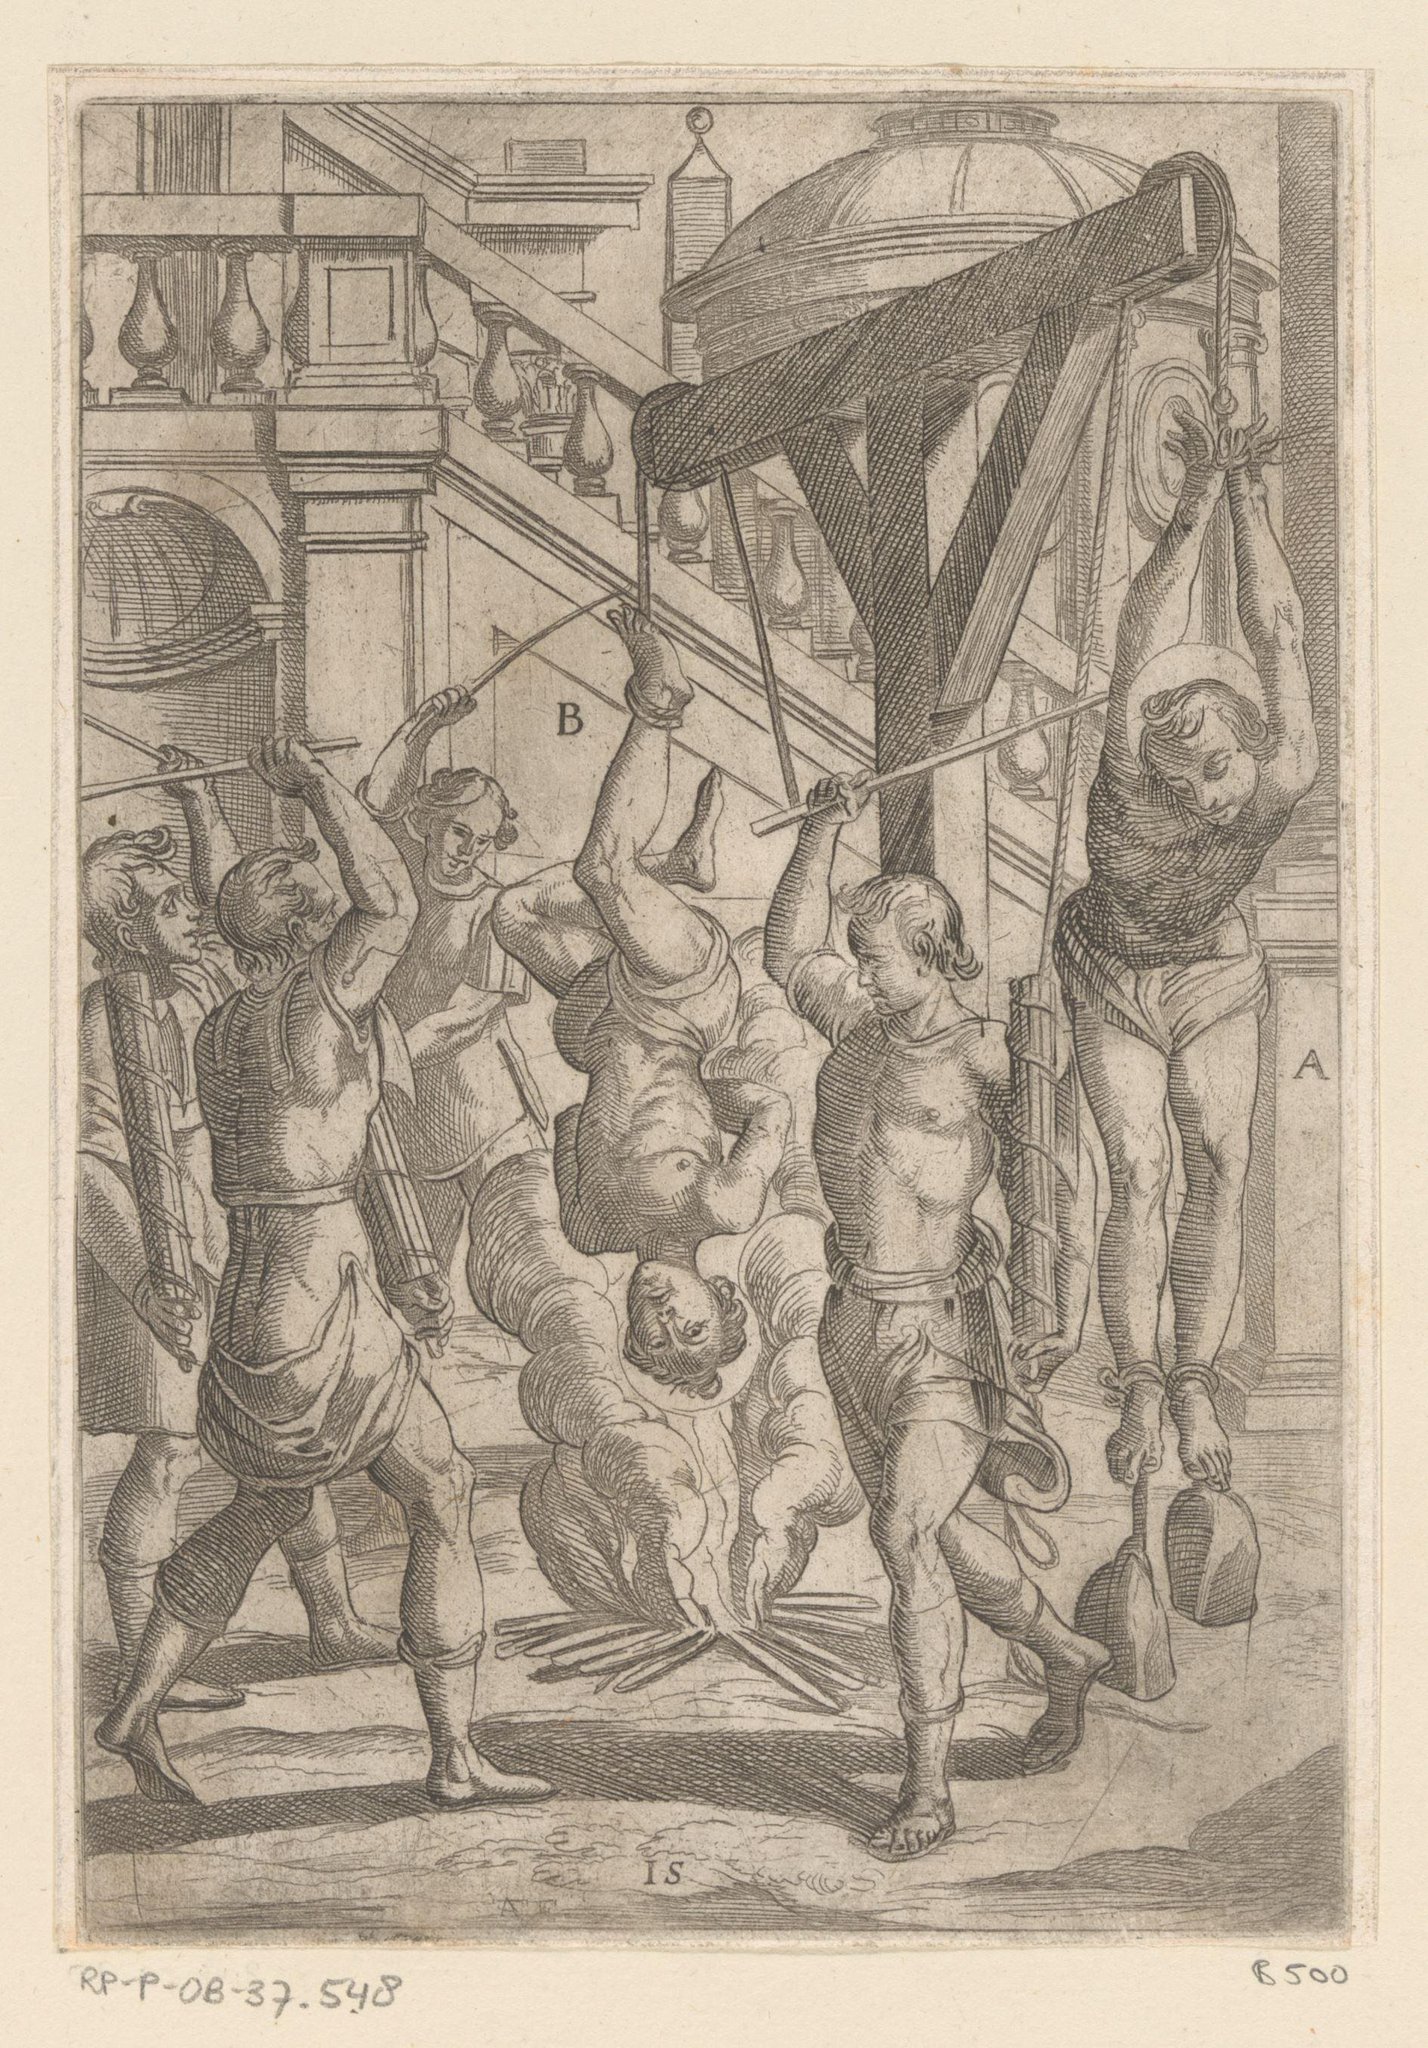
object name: print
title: Verbranding ondersteboven hangend en slaan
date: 1565-1630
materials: paper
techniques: etching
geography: italy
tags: violent death ~ maltreatment, torture, torture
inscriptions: collector's mark: Lugt 240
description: Deze prent maakt deel uit van een reeks van 47 prenten (+ titelprent) met voorstellingen van martelmethoden. Deze prenten zijn in een andere editie gebruikt als illustraties voor Antonio Gallonio's 'Trattato degli Instrumenti di Martirio e delle Varie Maniere di Martoriare Usate dai Gentili contro Christiani' (Rome, Ascanio en Girolamo Dongangeli, 1591).